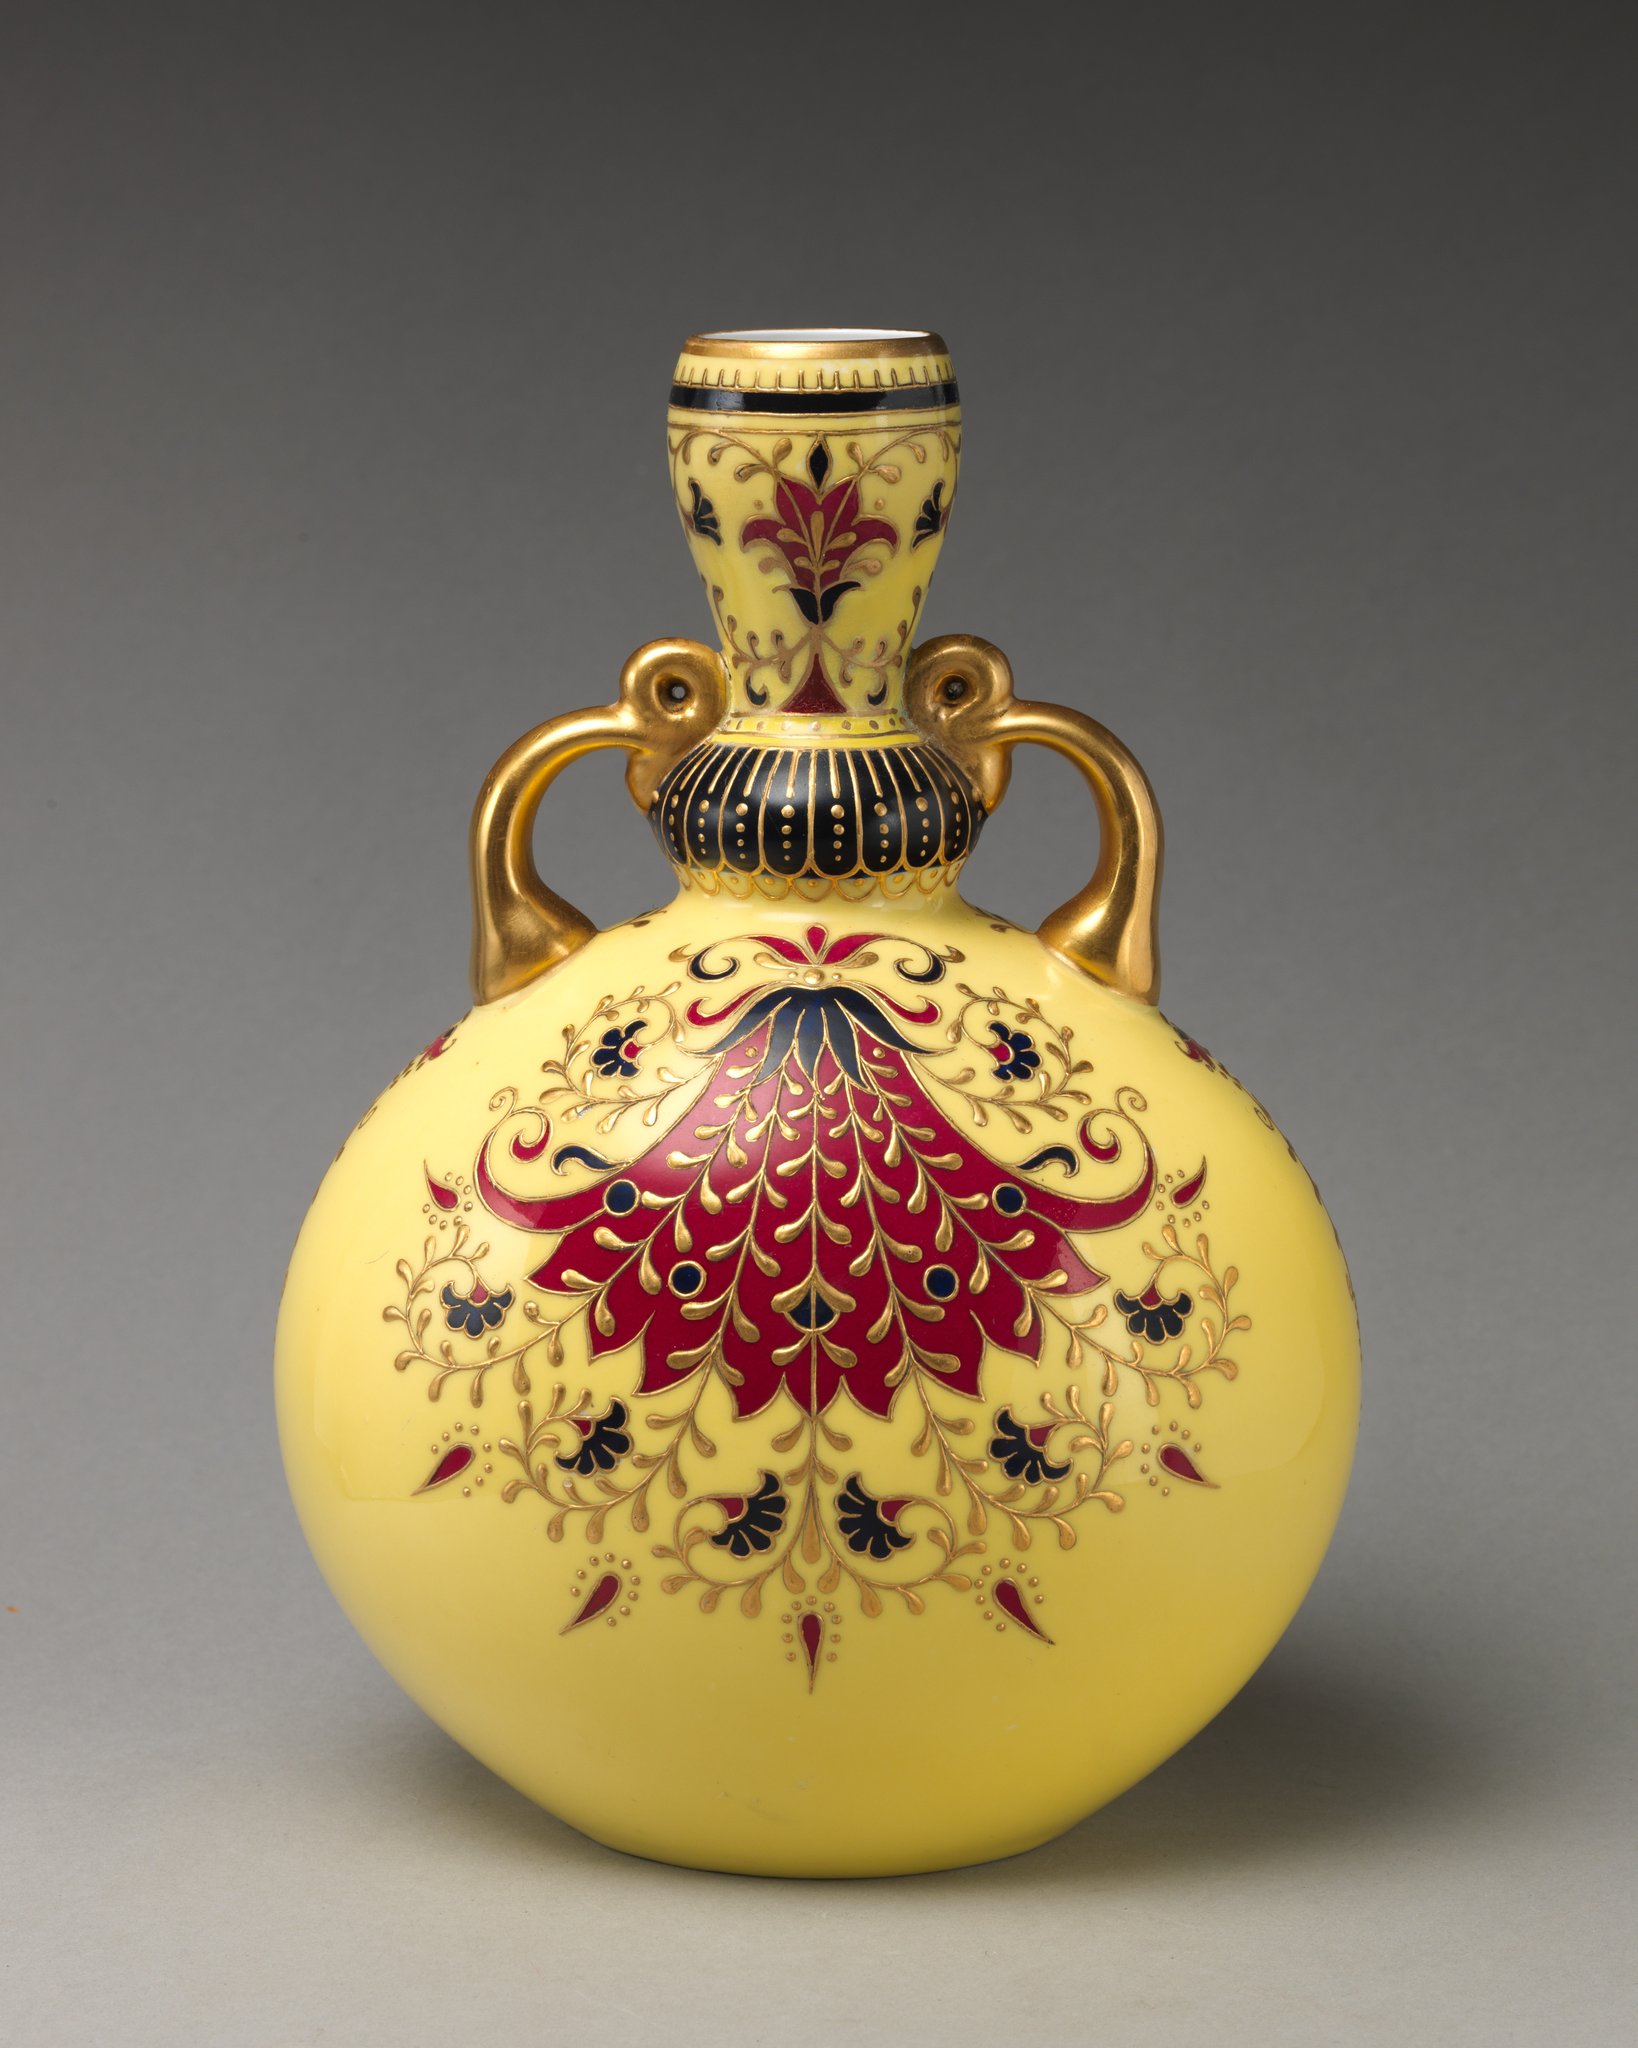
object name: vase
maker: minton(s)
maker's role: maker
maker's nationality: british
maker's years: 1793-2001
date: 1891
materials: bone china, enamel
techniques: gilding